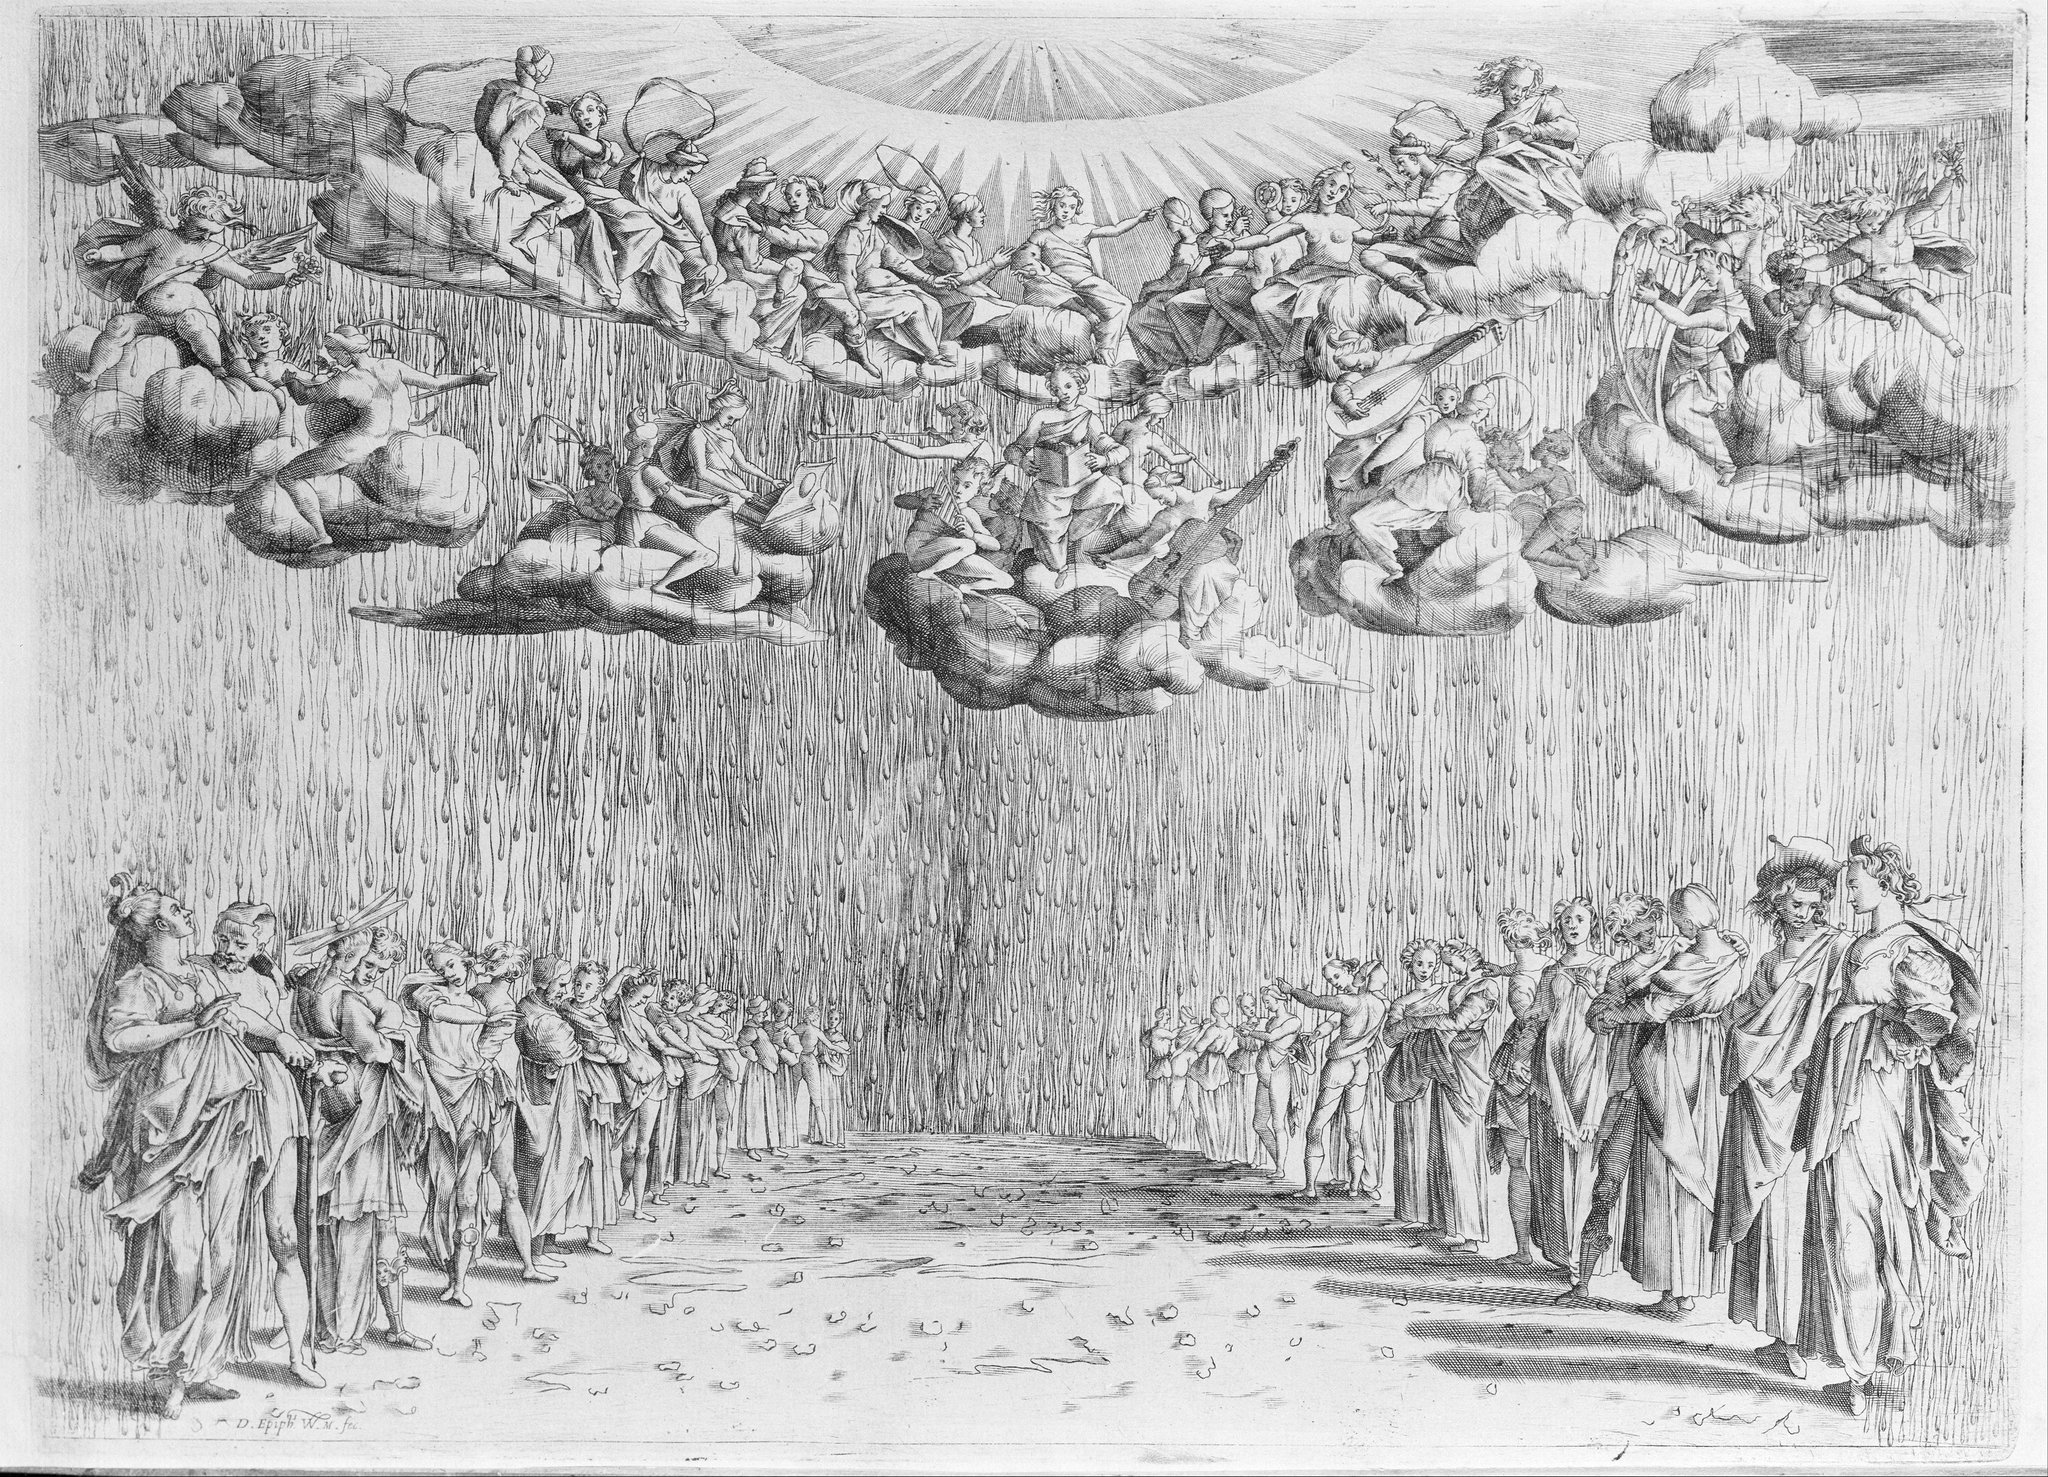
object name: book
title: Design for the Stage for 'Intermedio 6', from an Album with Plates documenting the Festivities of the 1589 Wedding of Ferdinand I and Christine of Lorraine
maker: epifanio d'alfiano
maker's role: artist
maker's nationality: italian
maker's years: 1581-1607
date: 1589-1592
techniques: etching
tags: musical instruments,men,women